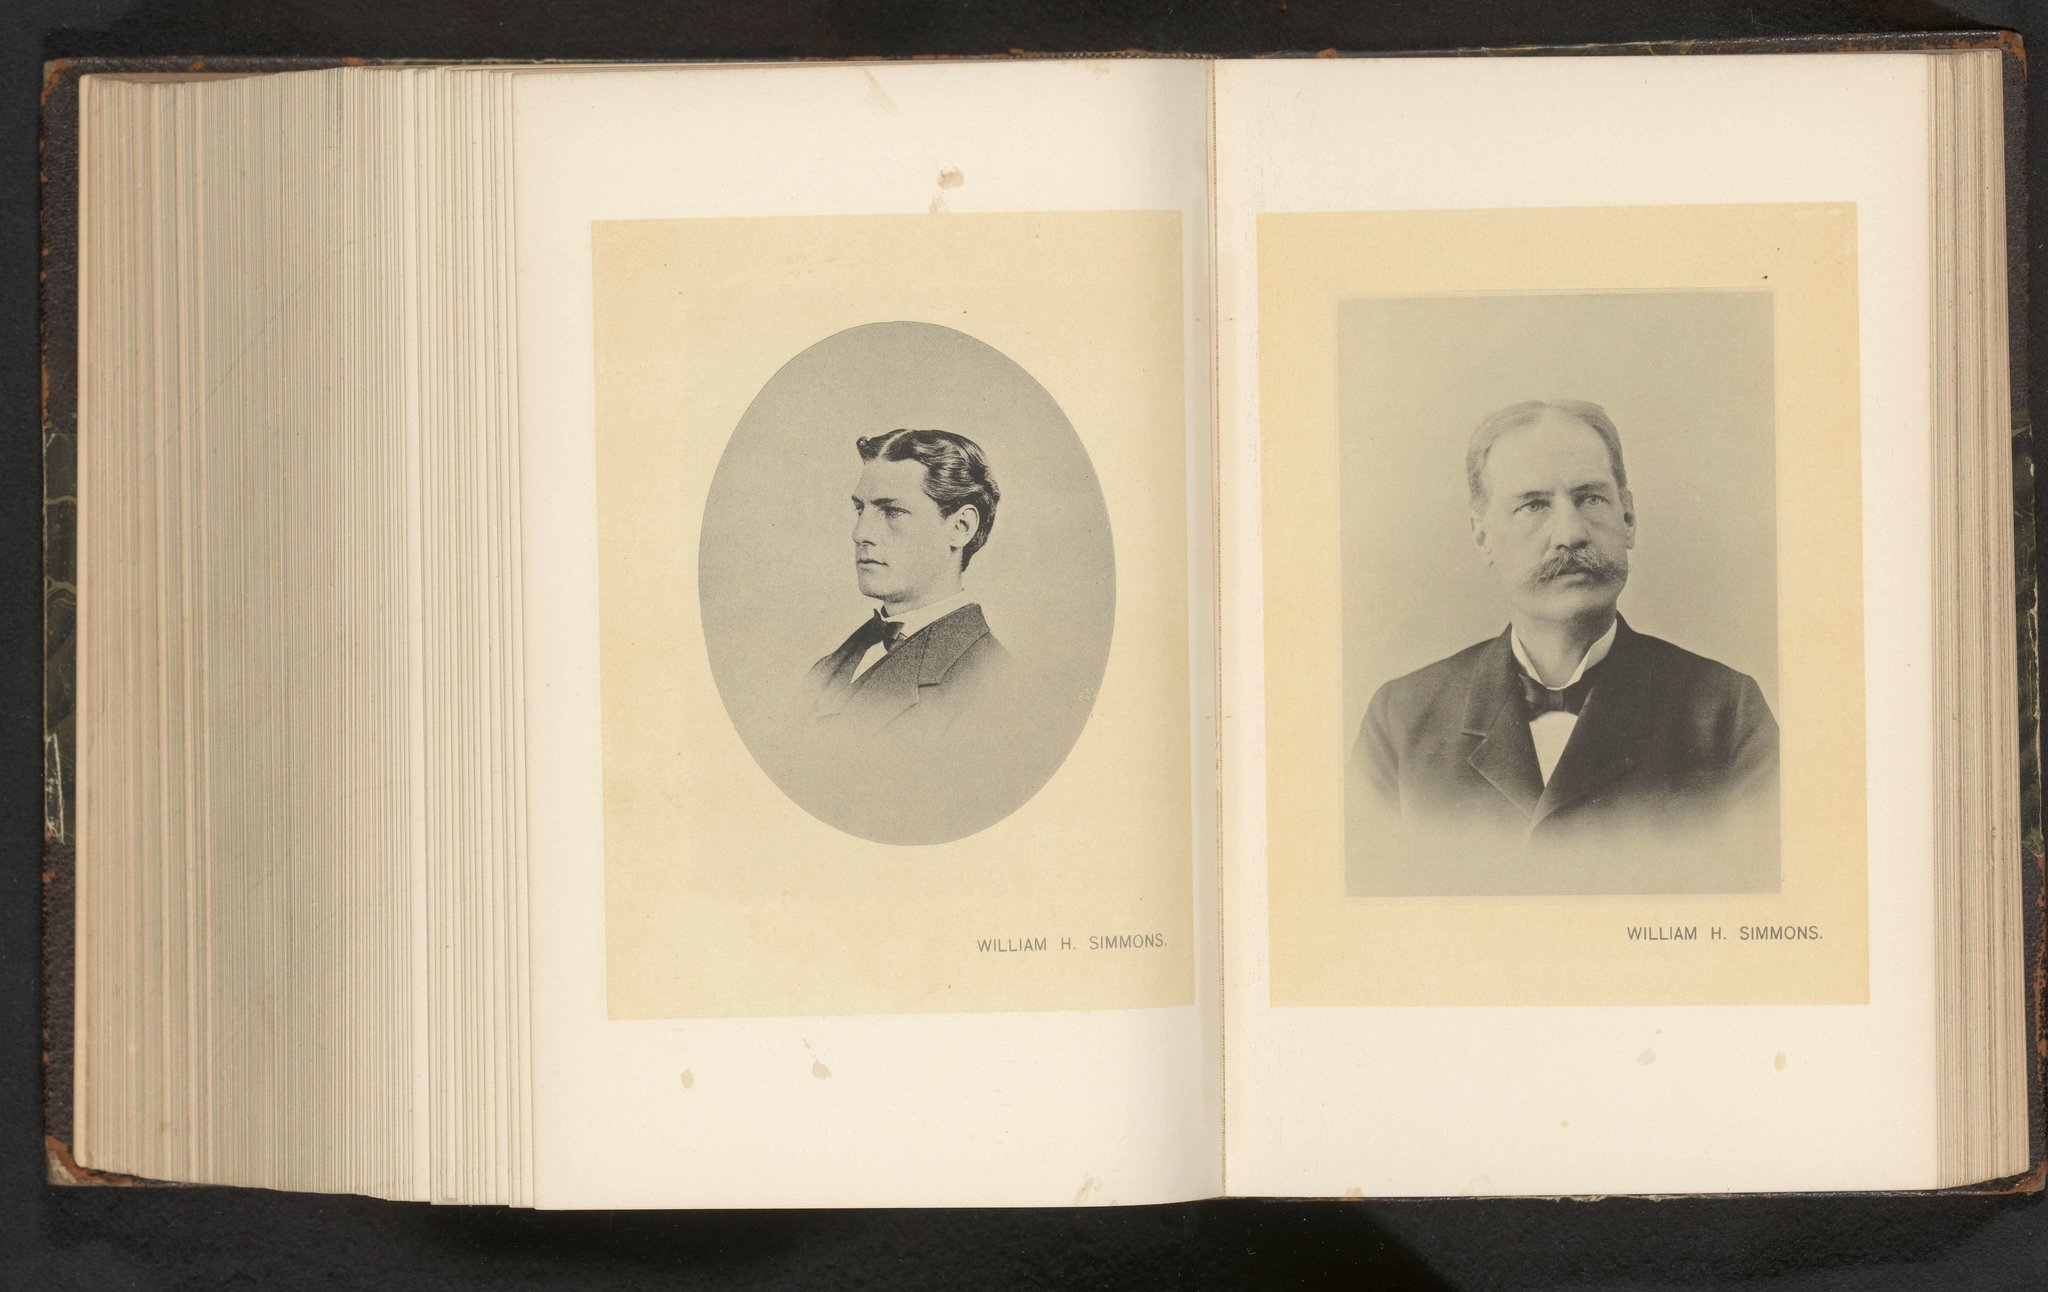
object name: photomechanical print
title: William H. Simmons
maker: Anonymous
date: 1889-1894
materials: paper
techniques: photoaquatint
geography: boston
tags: adult man